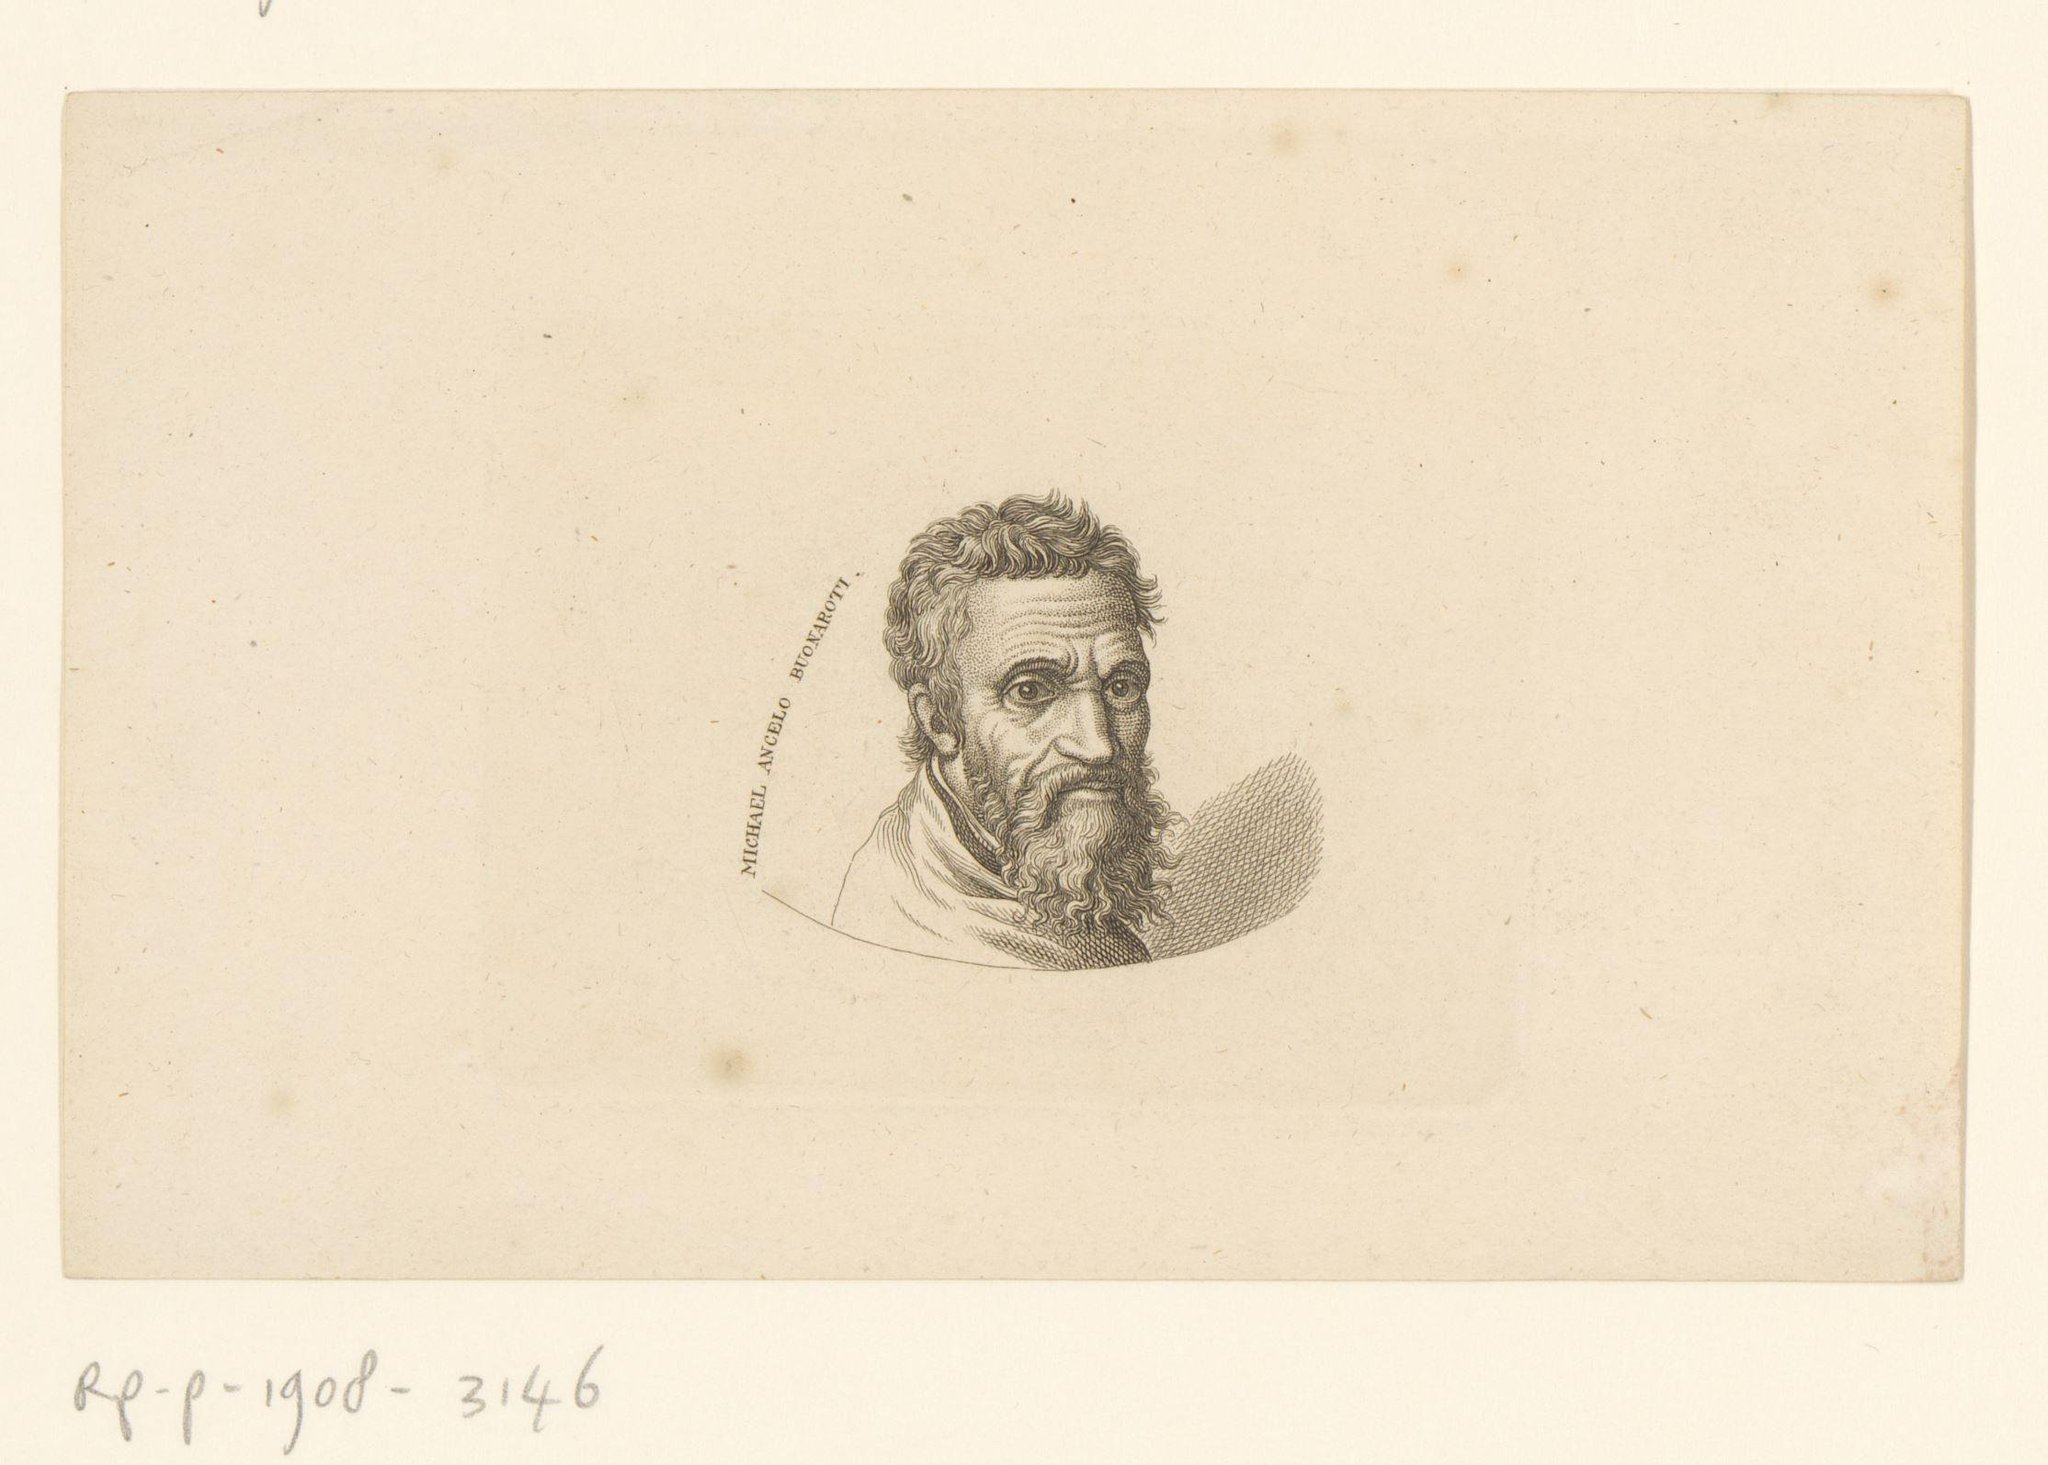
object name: print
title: Portret van Michelangelo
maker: ernst ludwig riepenhausen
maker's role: print maker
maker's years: 1765-1840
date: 1775-1840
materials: paper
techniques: engraving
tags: rome, painter, draughtsman, sculptor, michelangelo, historical persons, portrait, self-portrait of painter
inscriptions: collector's mark: Lugt 2228